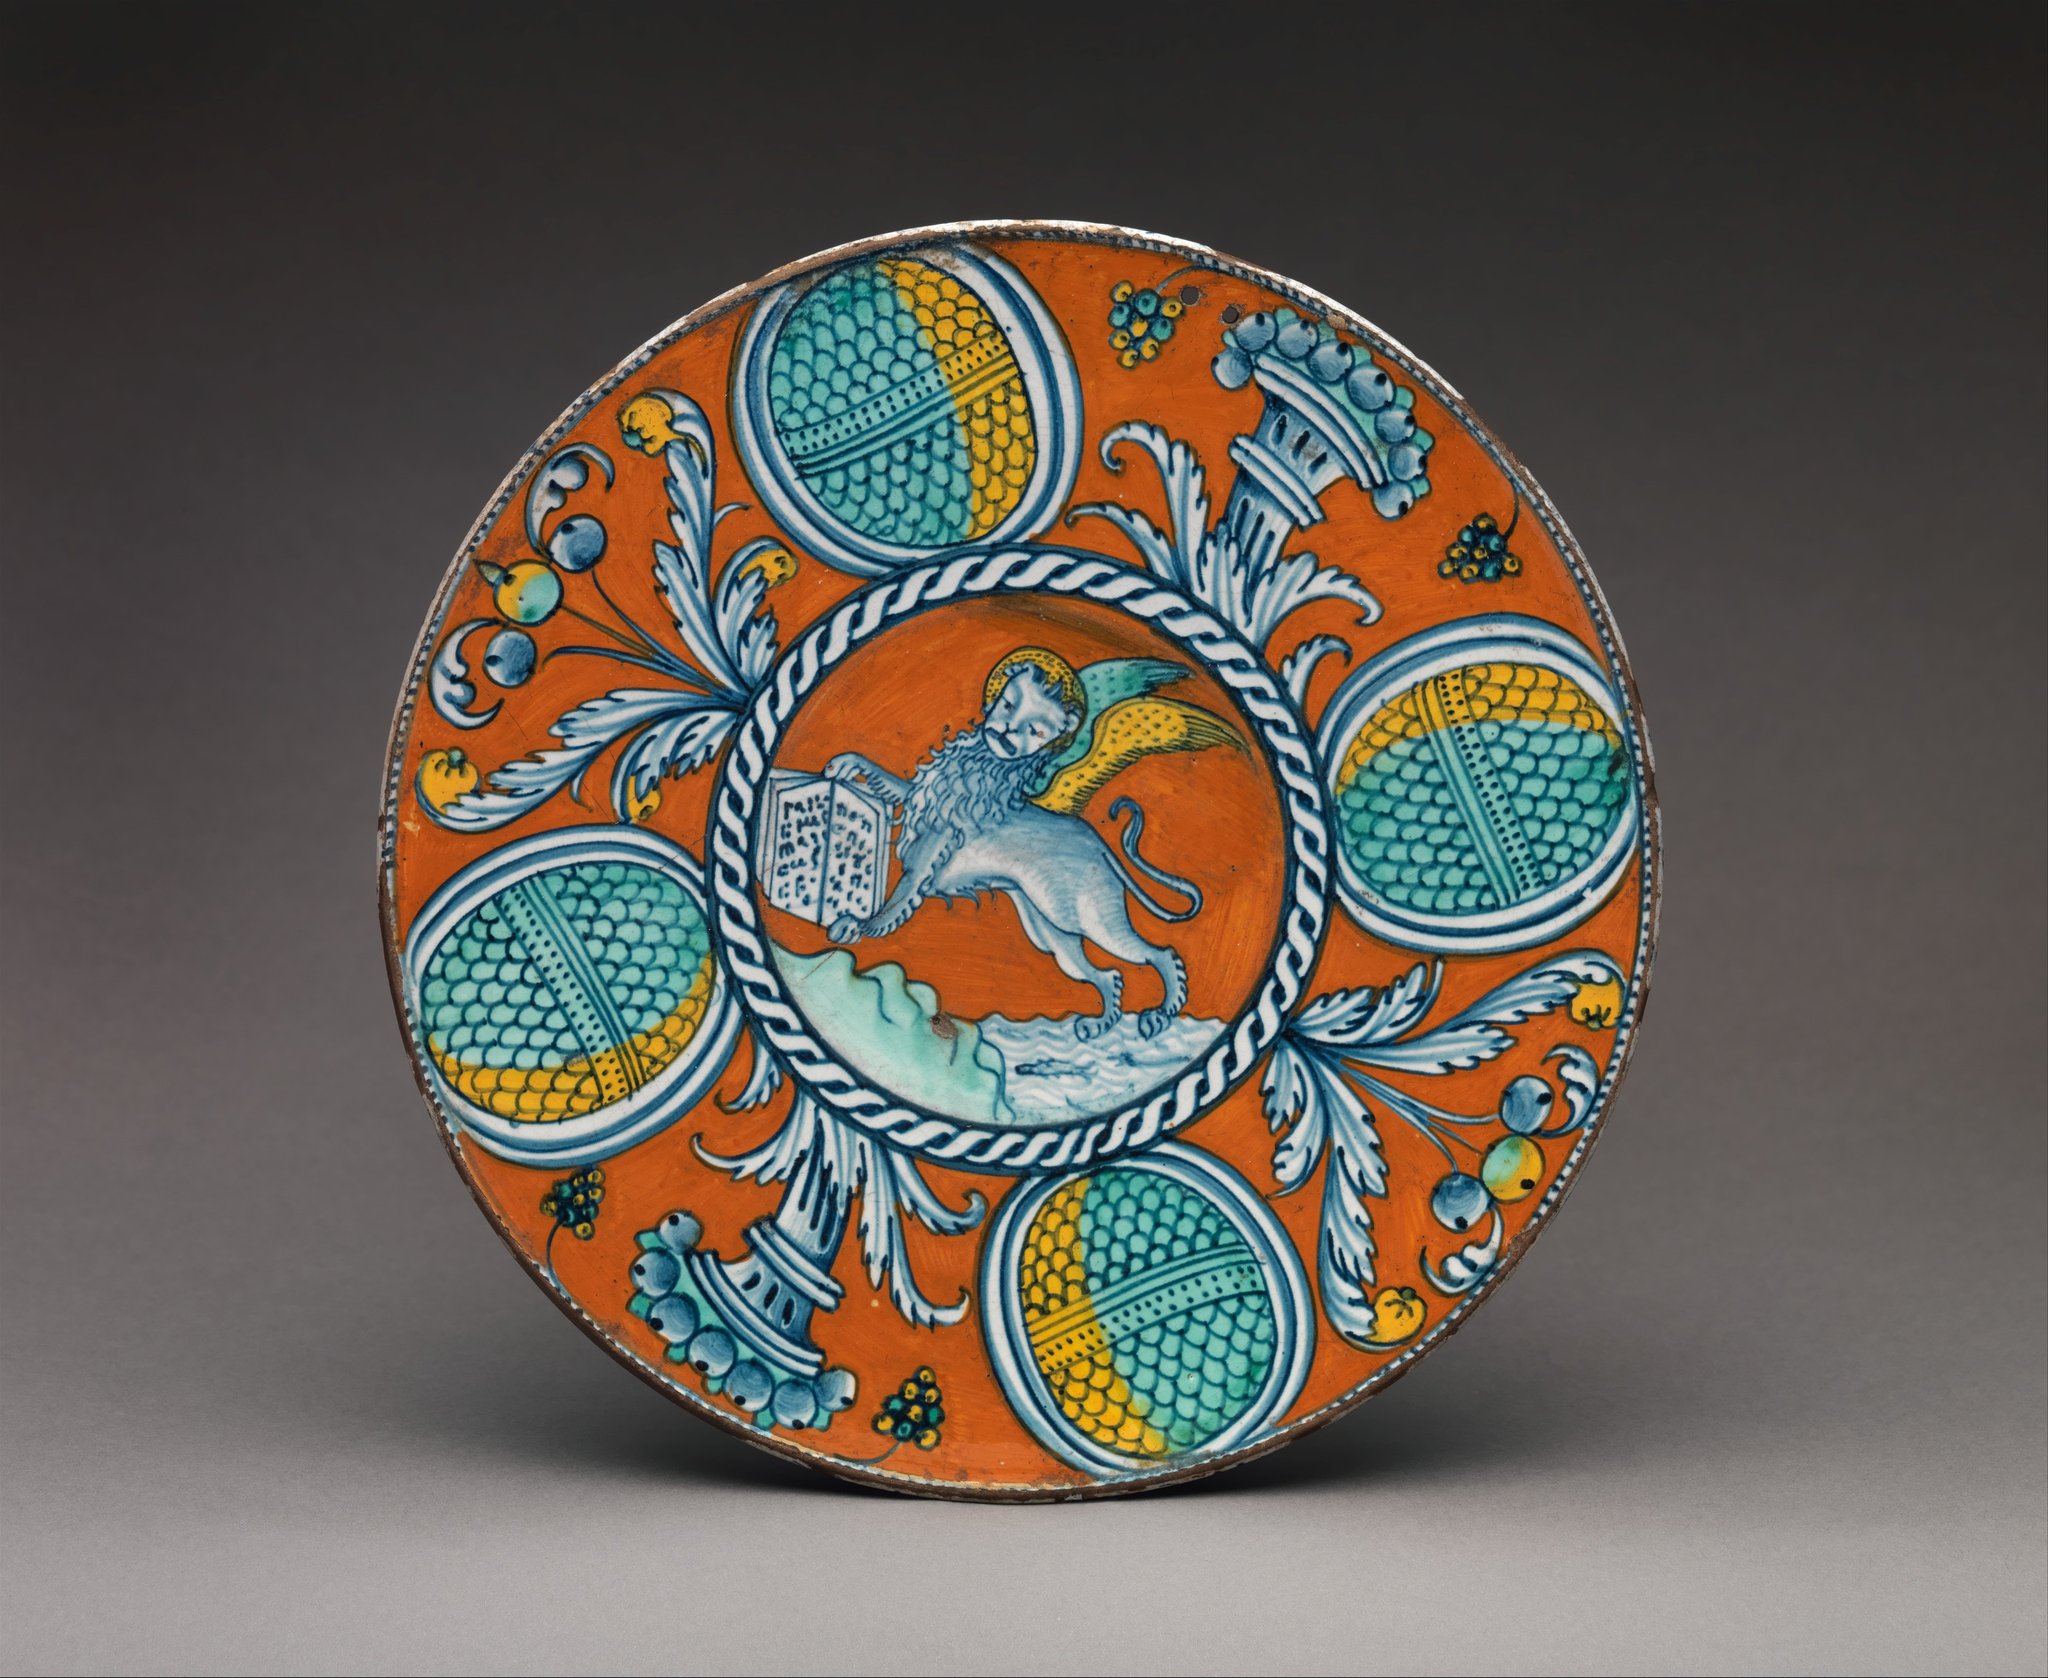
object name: plate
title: Plate with Lion of Saint Mark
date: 1500-1510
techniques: maiolica, glazing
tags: lions